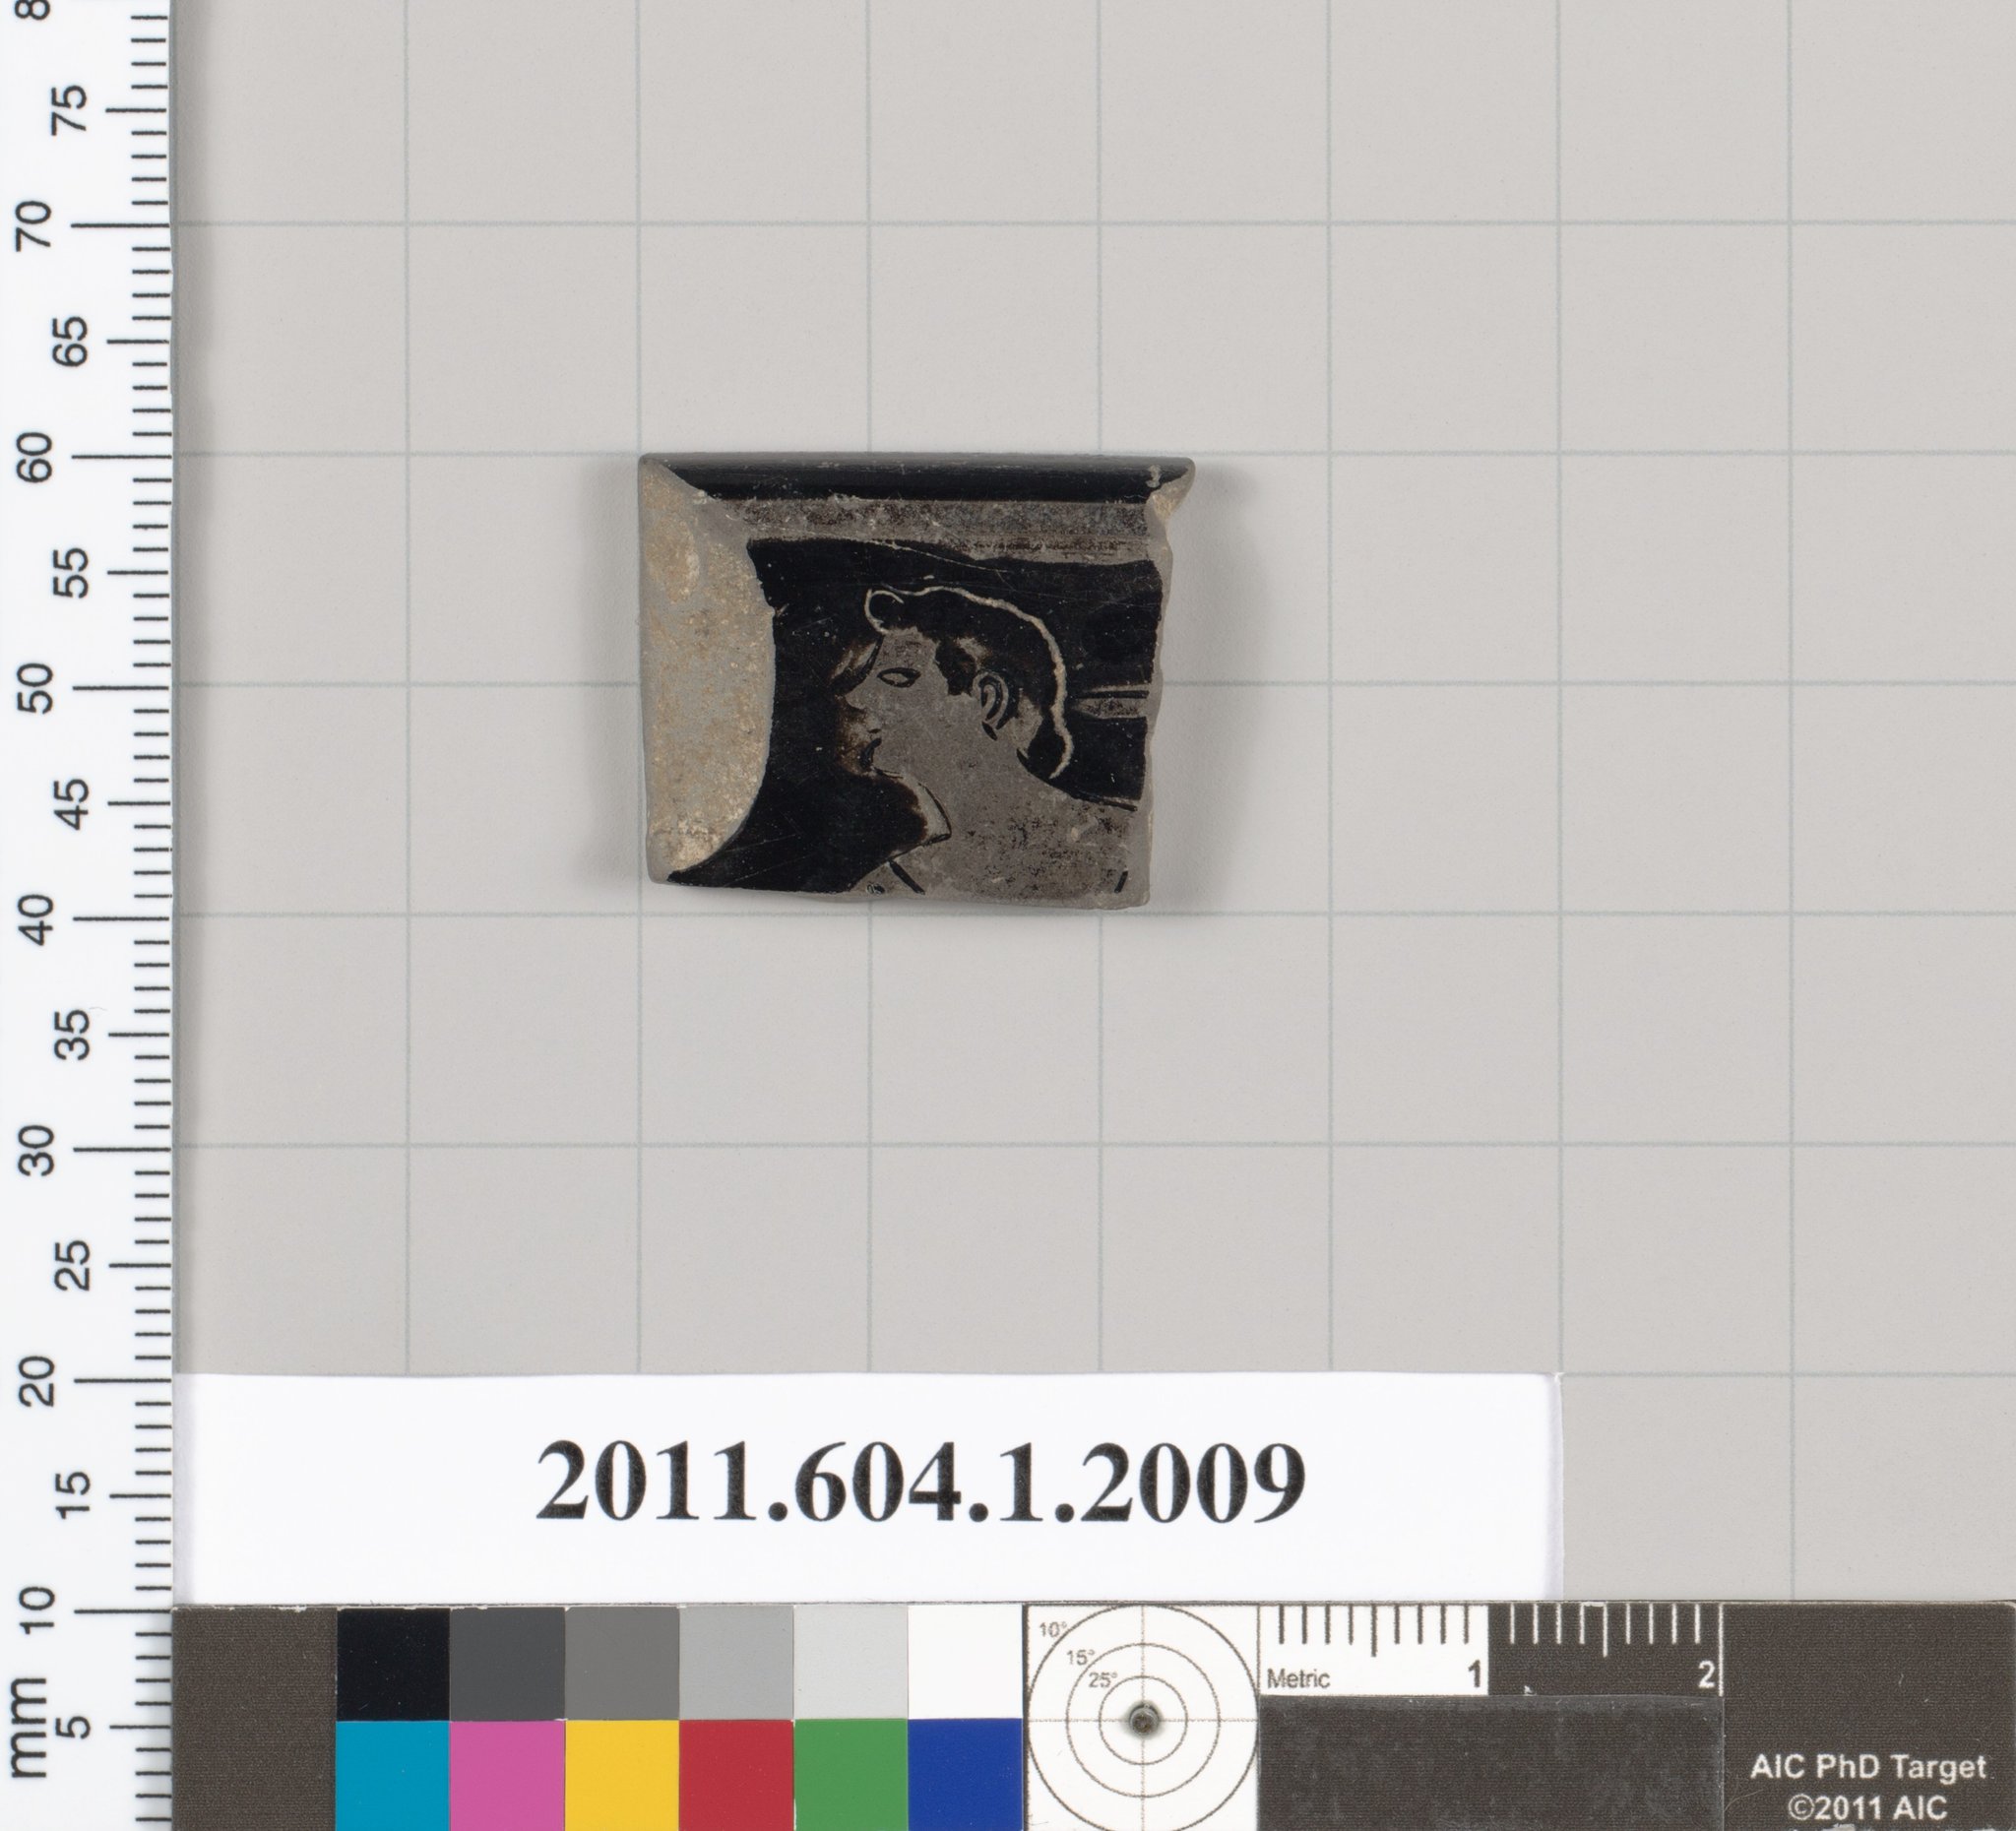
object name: kylix fragment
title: Terracotta rim fragment of a kylix (drinking cup)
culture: greek, attic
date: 500-451 BCE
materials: terracotta